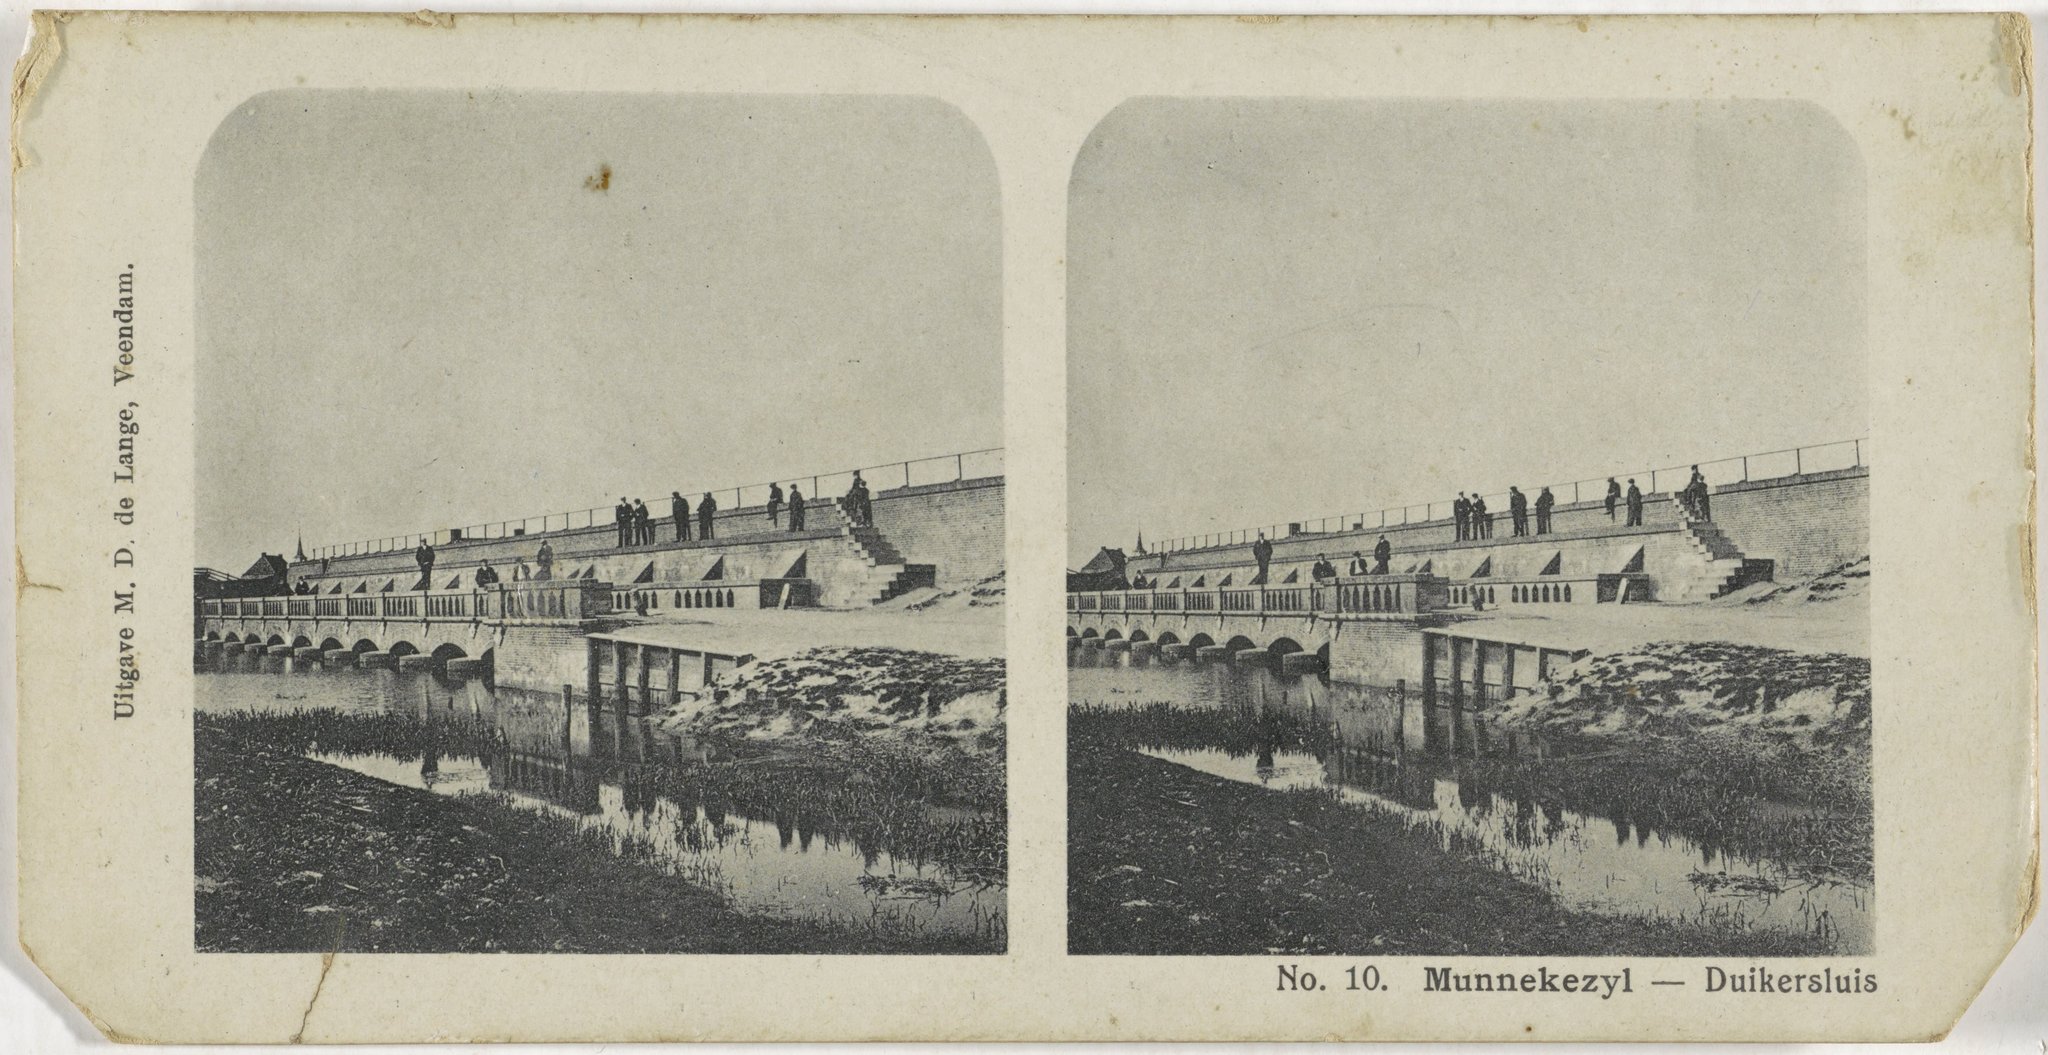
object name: photomechanical print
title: Gezicht op de Duikersluis in Munnekezijl op de grens van Friesland en Groningen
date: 1900-1911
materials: paper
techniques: photograph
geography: munnekezijl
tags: lift-lock, canal lock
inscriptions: number: ‘No. 10.’